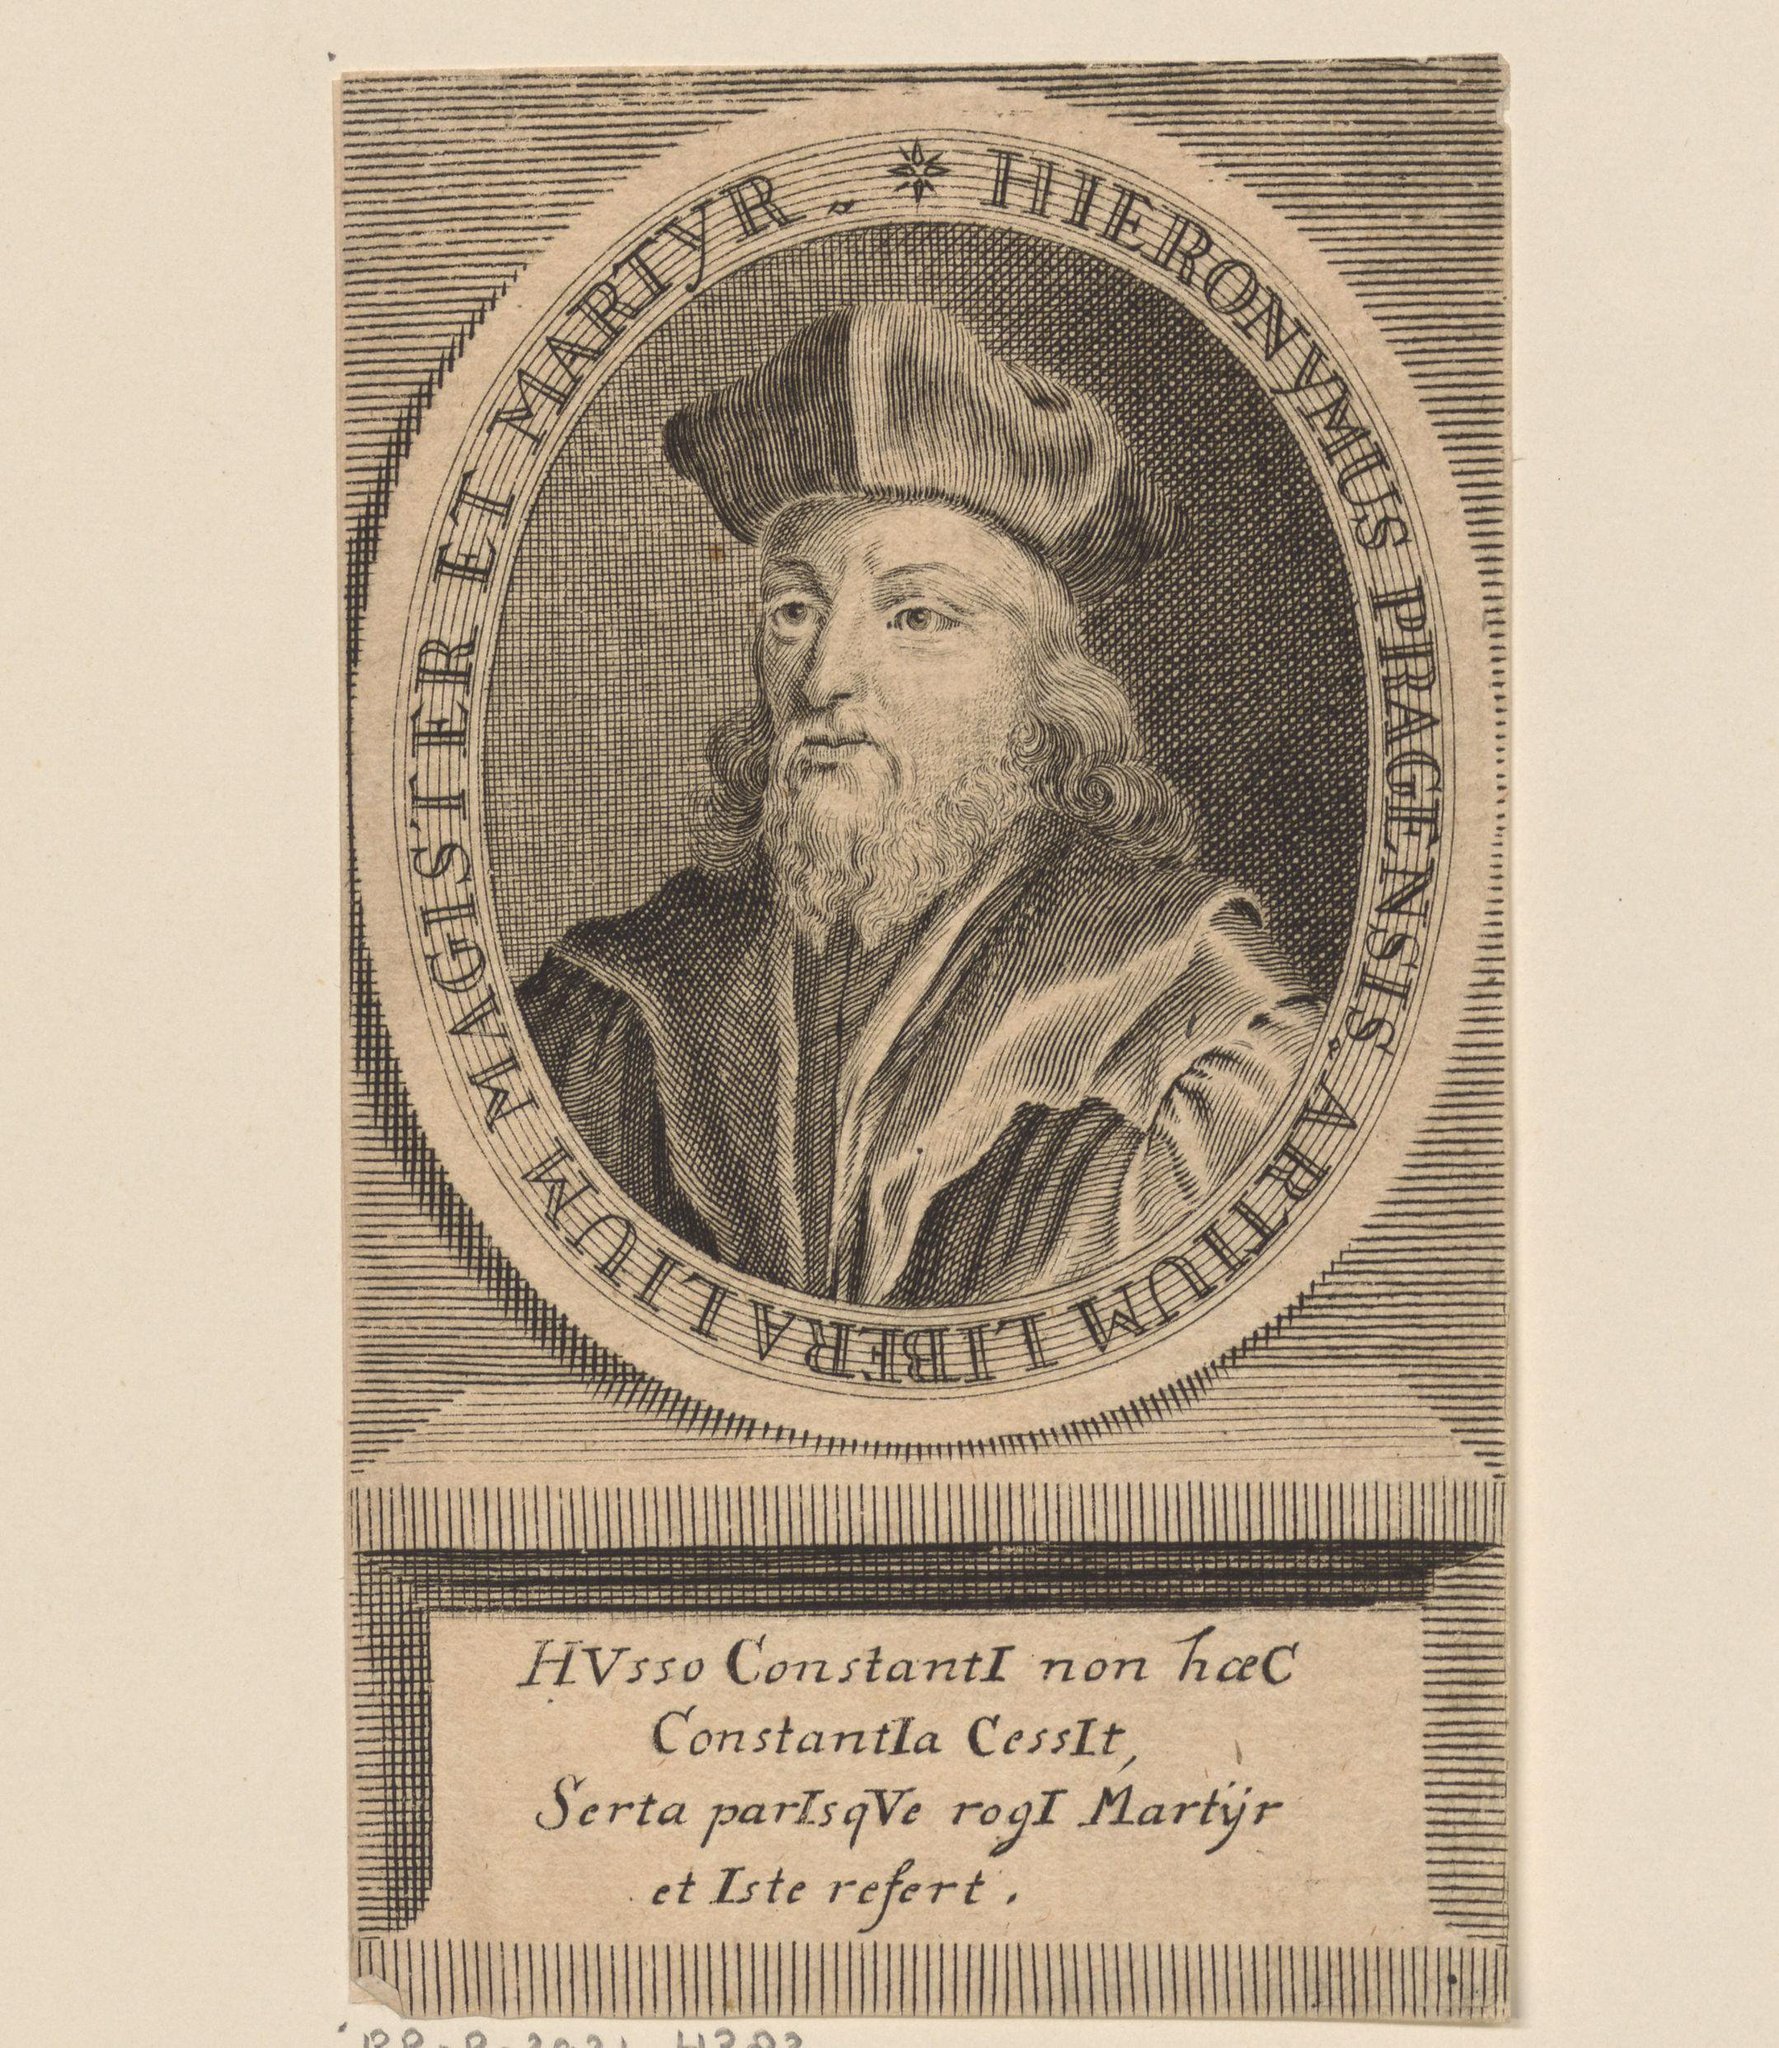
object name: print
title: Portret van Hiëronymus van Praag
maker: Anonymous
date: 1650-1749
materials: paper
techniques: engraving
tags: theologian, historical persons